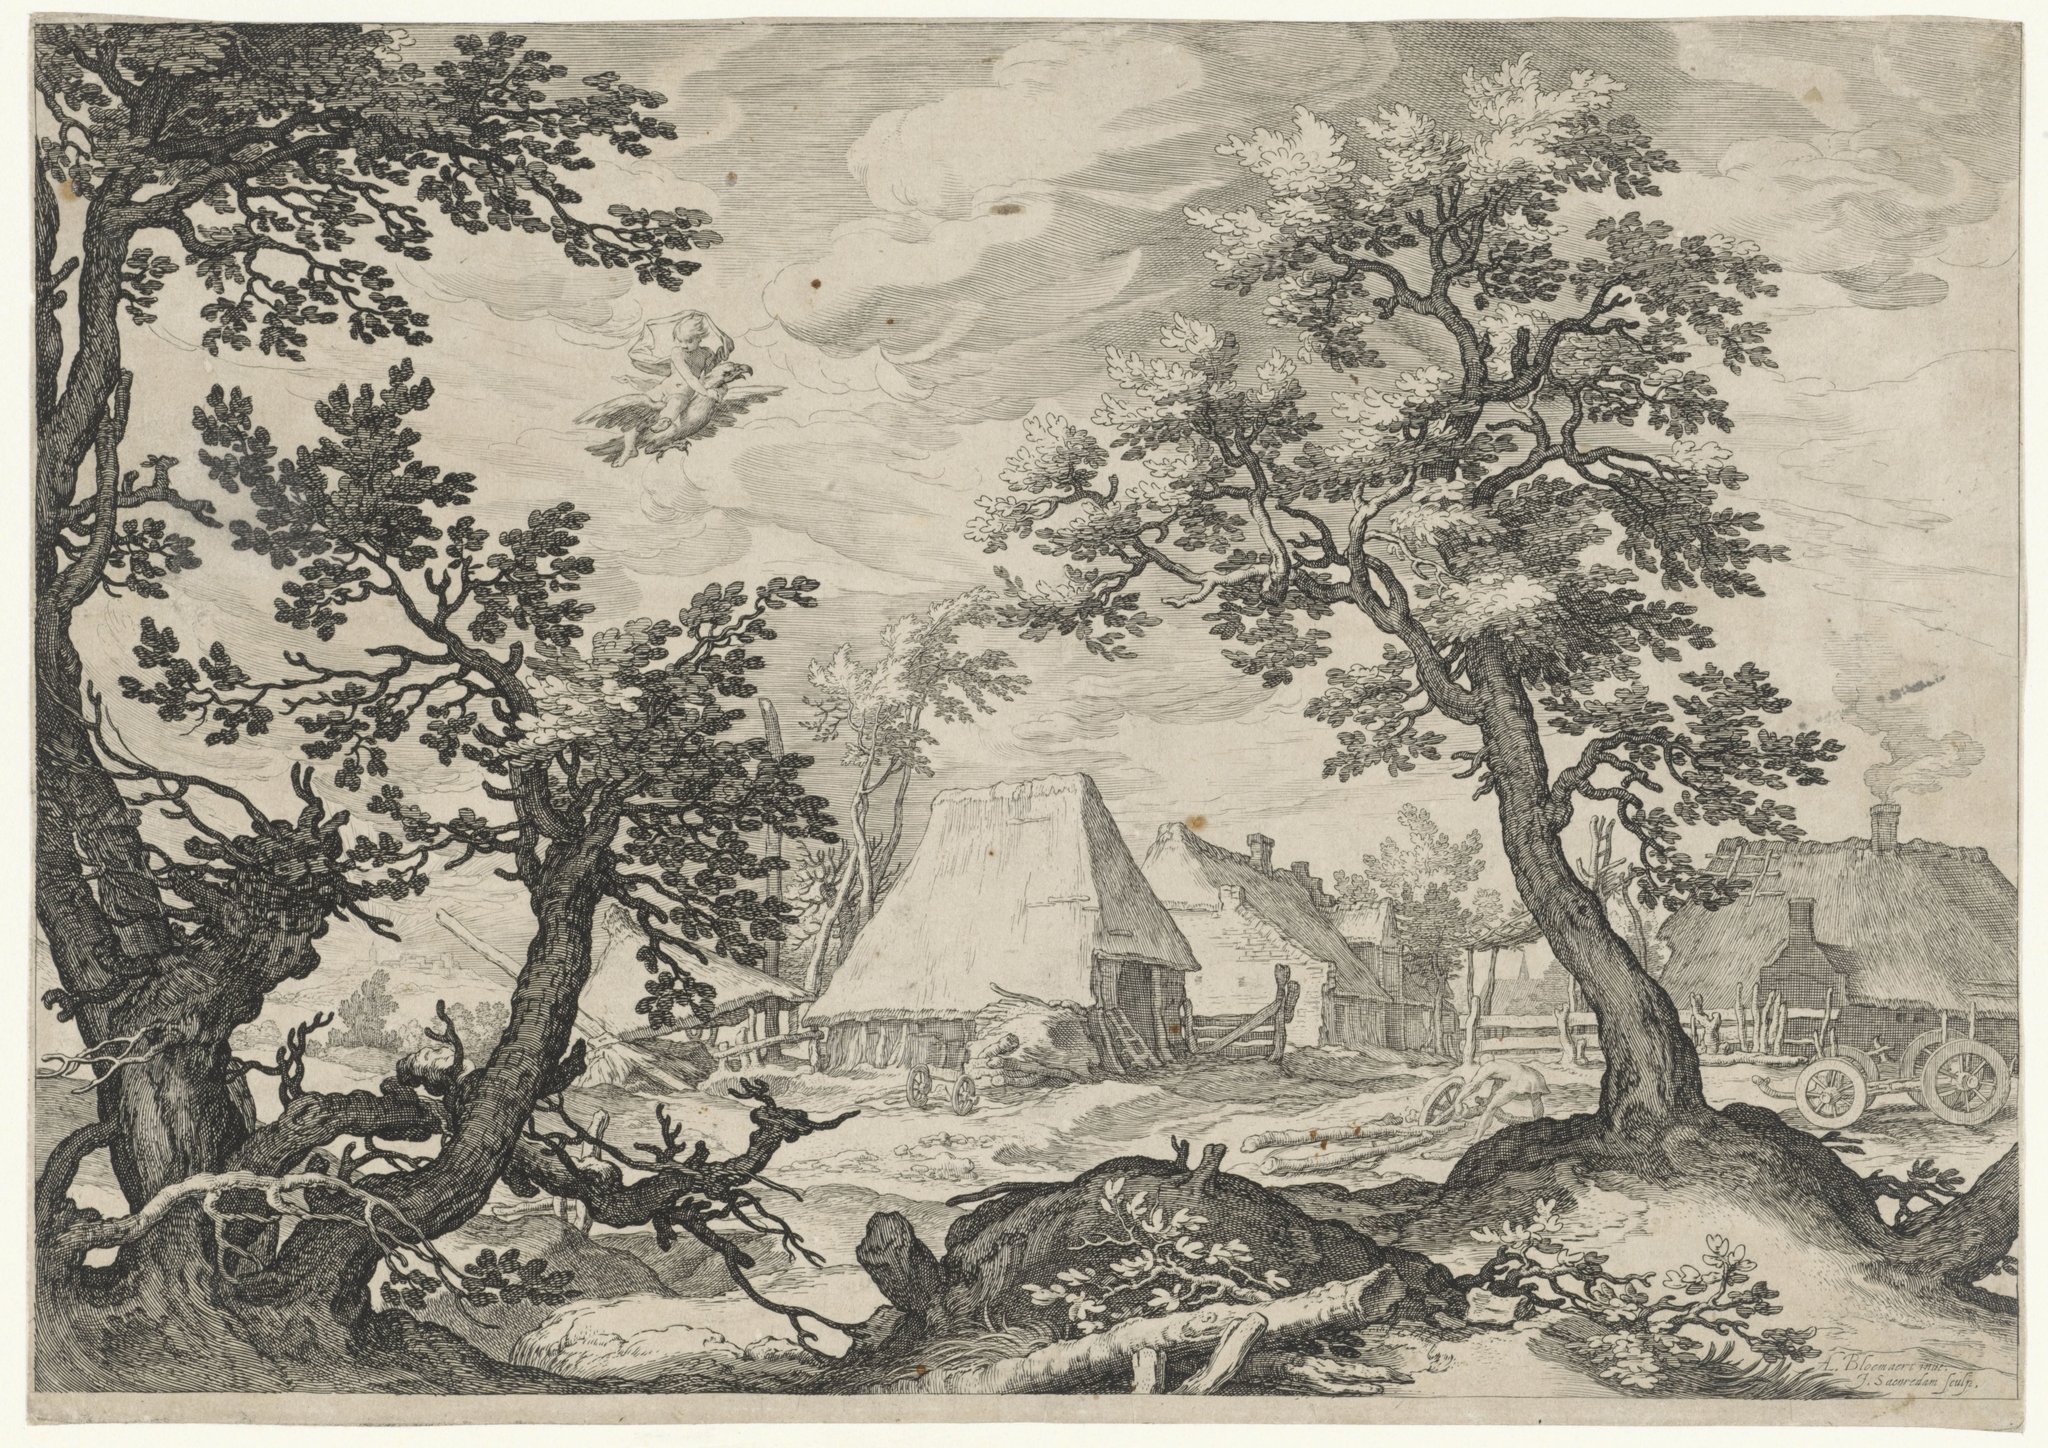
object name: print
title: Landschap met de ontvoering van Ganymedes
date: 1575-1607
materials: paper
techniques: engraving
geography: northern netherlands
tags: the rape of ganymede: he is carried off through the air by jupiter in the form of an eagle, or by the eagle of jupiter, farm or solitary house in landscape, farm (building)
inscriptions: collector's mark: Lugt 240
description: Een landschap met enkele boerderijen. In de lucht Ganymedes, die door Jupiter in de gedaante van een adelaar naar Olympus wordt gevoerd.